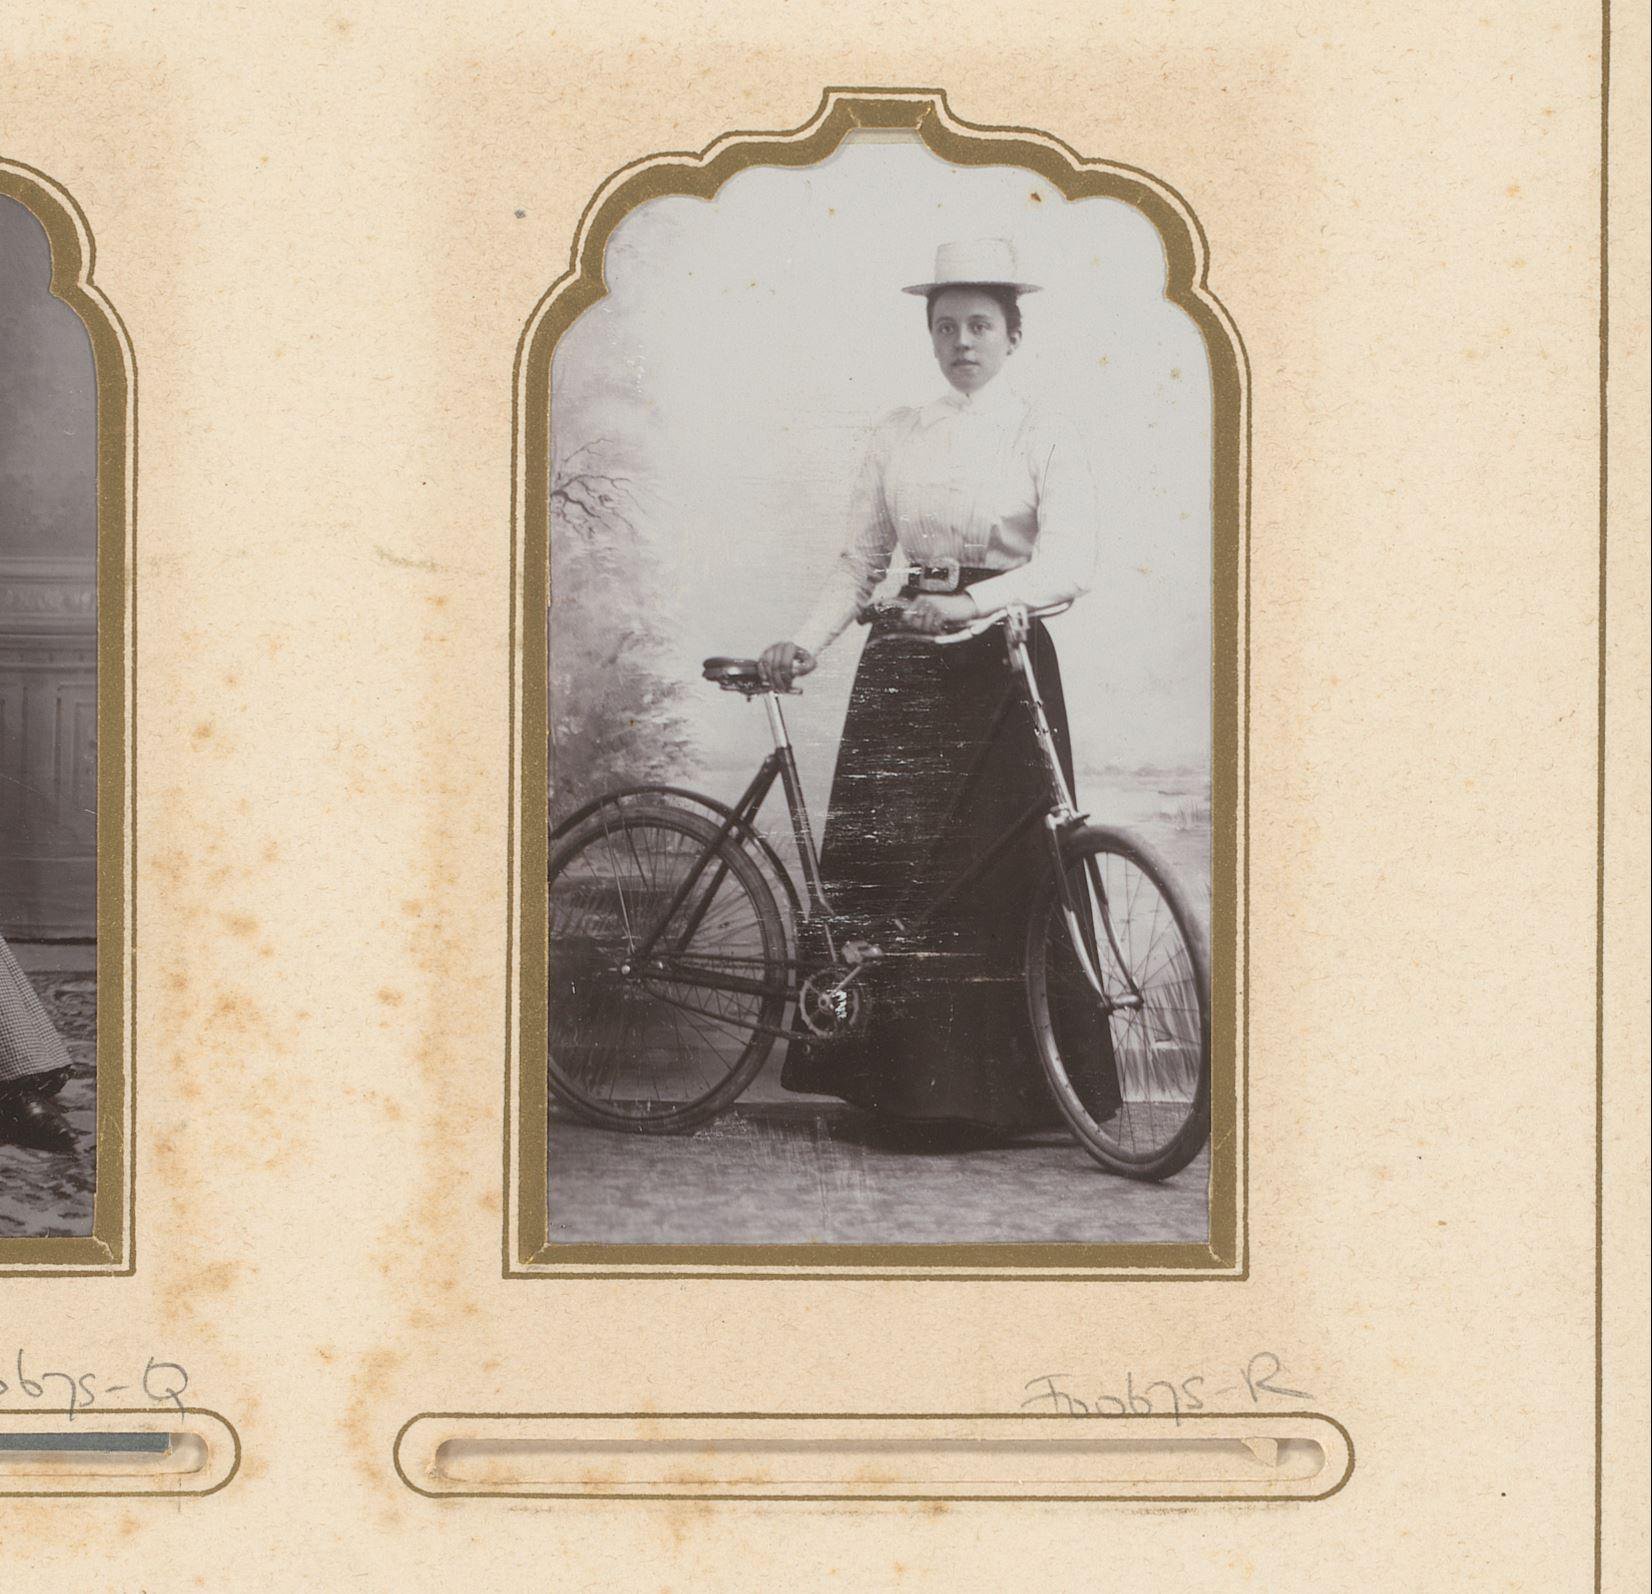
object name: album leaf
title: Portret van een staande vrouw met hoed en fiets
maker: anton cornelis thomann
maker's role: fotograaf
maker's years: 1873-1946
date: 1891-1928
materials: cardboard, photographic support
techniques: collodion silver print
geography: utrecht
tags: historical persons - bb - woman, bicycle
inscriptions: inscription: ‘Anton C. Thomann/ Utrecht/ Witte Vrouwe Singel 89 (...)’